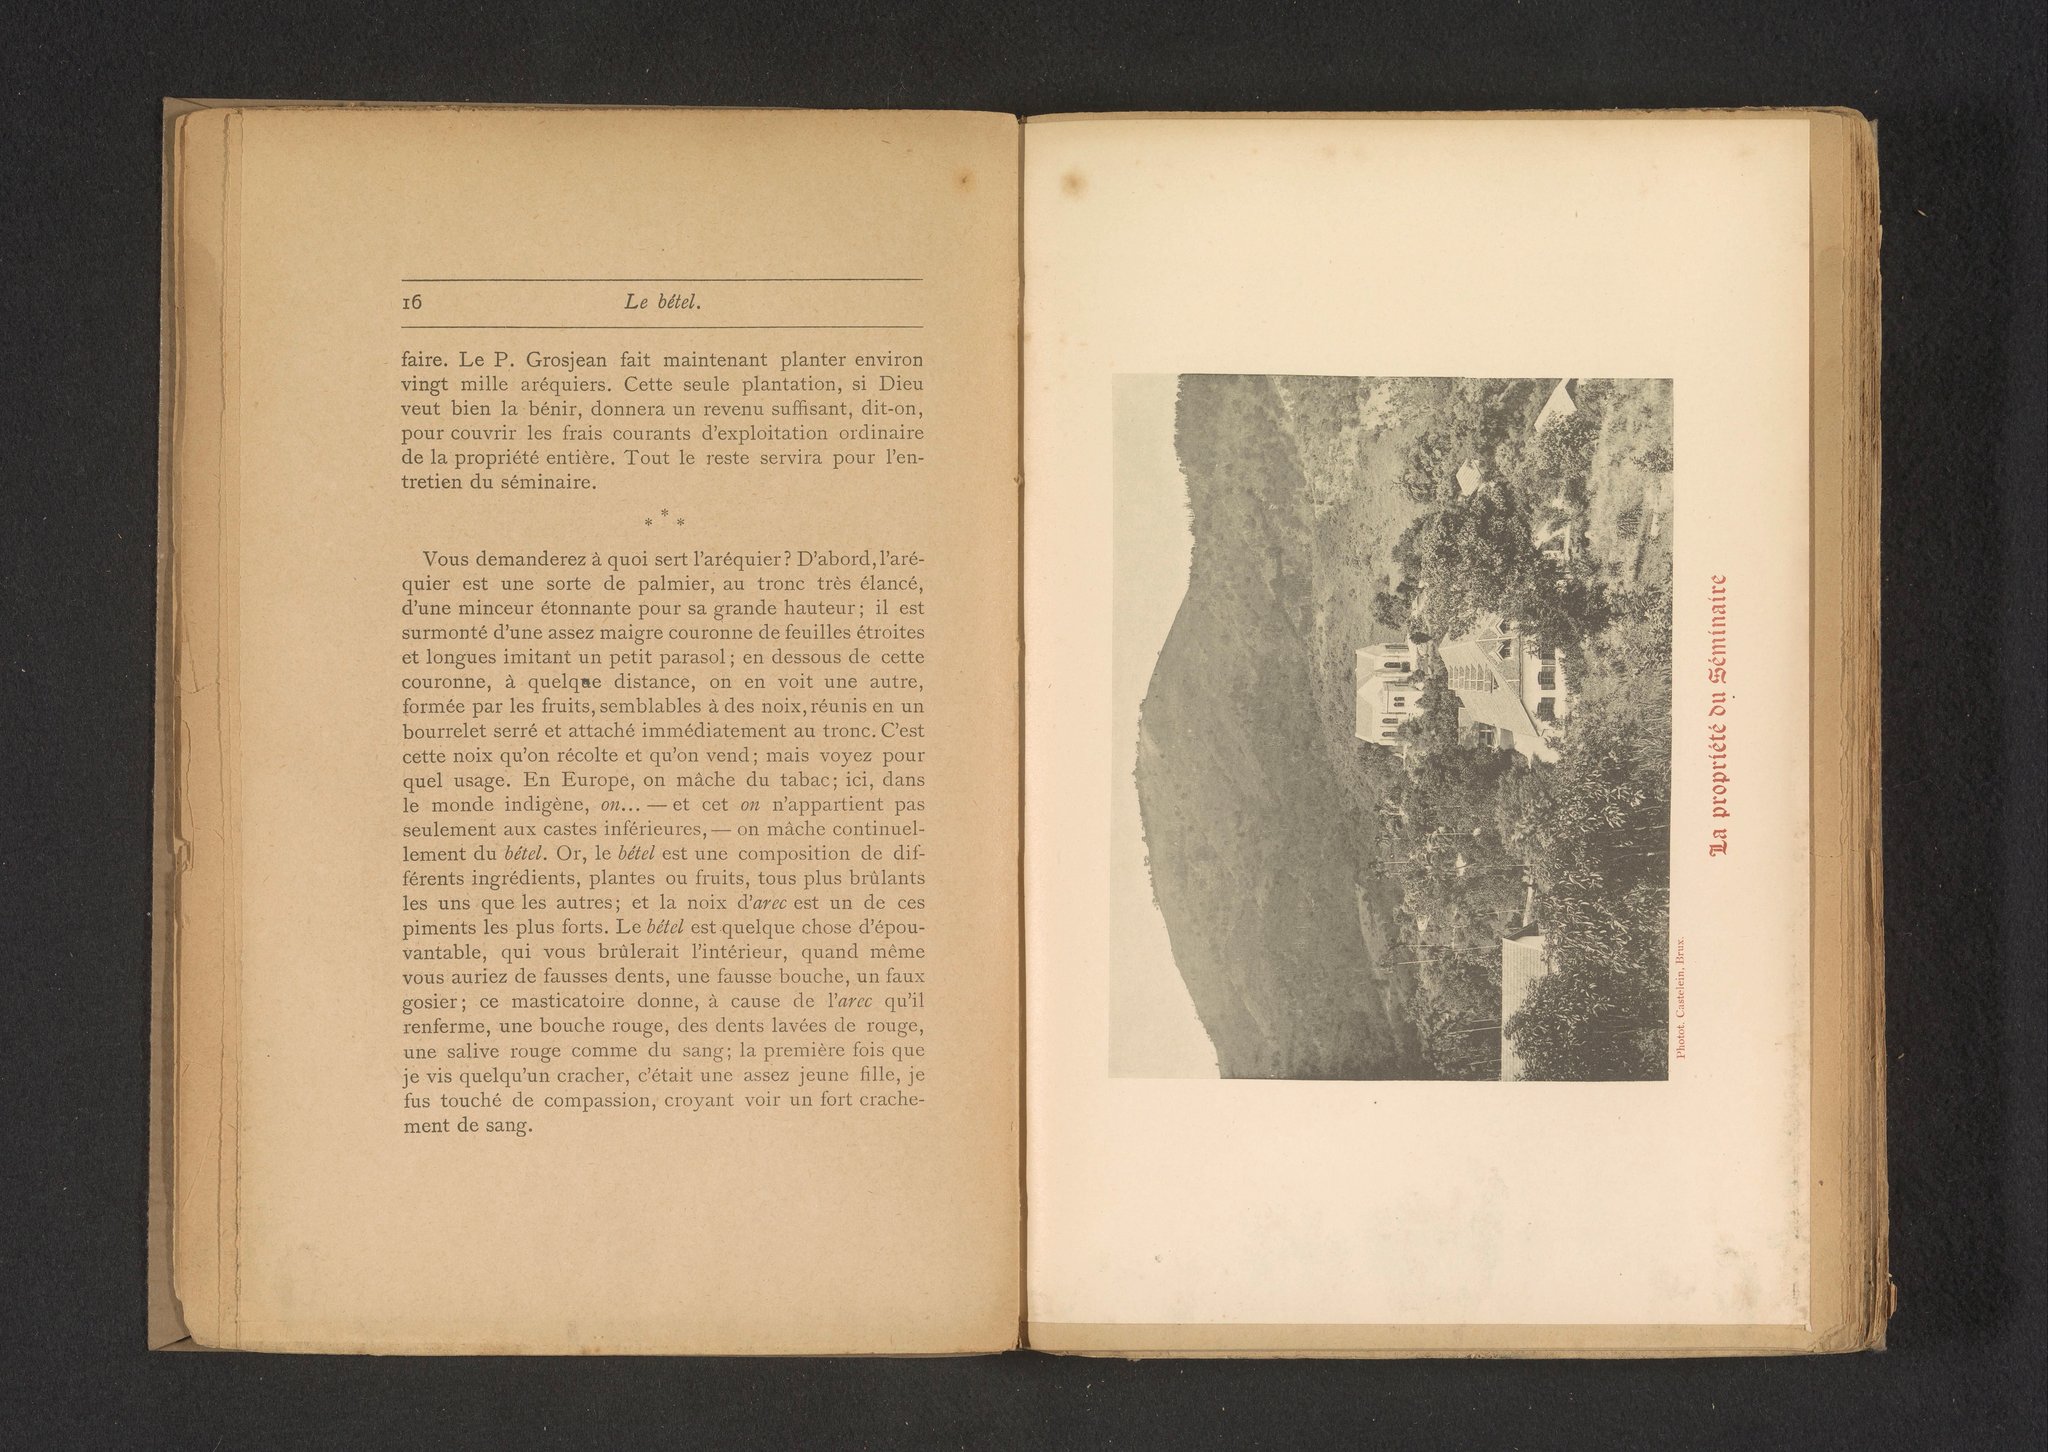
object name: photomechanical print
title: Gezicht op een klooster in de bergen in Sri Lanka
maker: e. castelein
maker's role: printer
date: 1894-1899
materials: paper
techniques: photograph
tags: abbey, monastery, convent ~ roman catholic church, mountains, sri lanka